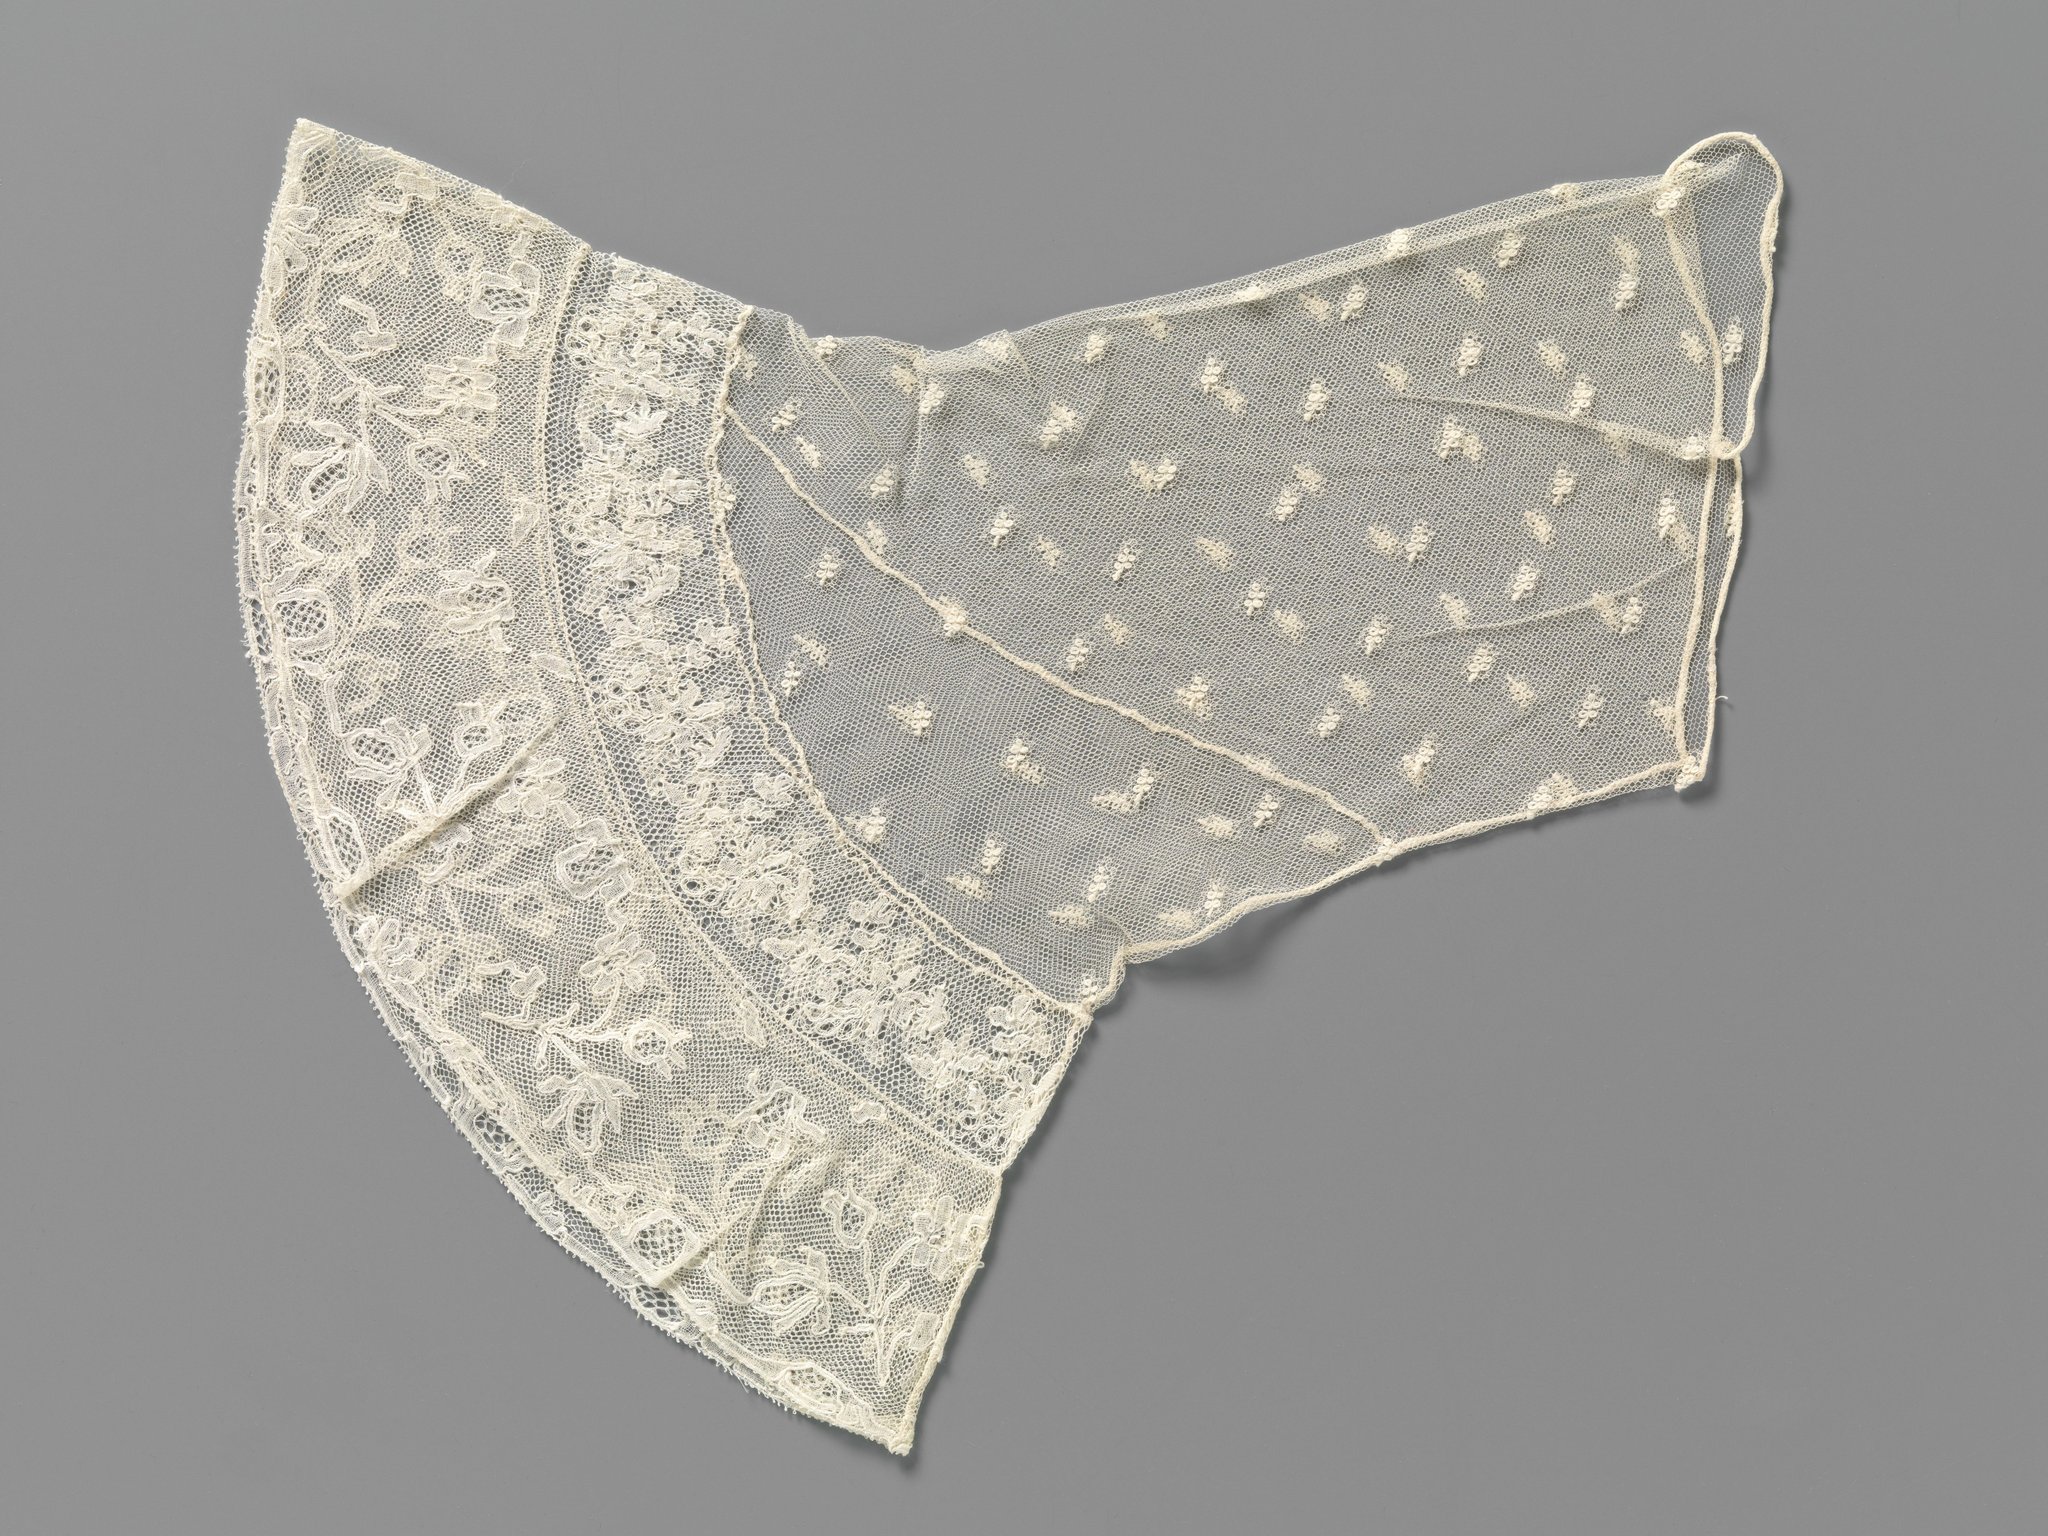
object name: womenswear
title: Ondermouw van kantborduurwerk met een manchet bestaande uit twee soorten kloskant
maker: Anonymous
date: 1900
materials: linen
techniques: lace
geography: belgium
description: Ondermouw van kantborduurwerk - tuledoorstopwerk op machinale tule - en een manchet van twee stroken kloskant: Rijselse en Mechelse kant. De strook Rijselse kant is aan de ondermouw genaaid en de strook Mechelse kant onderaan de strook Rijselse kant. Pagodemodel. Op de machinale tule is een strooipatroon van bessentakjes geborduurd. Het zich herhalende patroon van de Rijselse kant bestaat uit een liggende tak met een rozetbloem, drie bessen en enkele grillig gevormde blaadjes. Het zich herhalende en symmetrische patroon van de Mechelse kant bestaat uit een hoefijzervormig boogje gevormd door twee bloemtakken met enkele verschillende bloemen. Langs de zeer vlakke schulpenrand liggen ovale veldjes gevormd door blaadjes of takjes, afgewisseld door een handvormig blad recht onder het boogje. De rand is afgewerkt met picots.